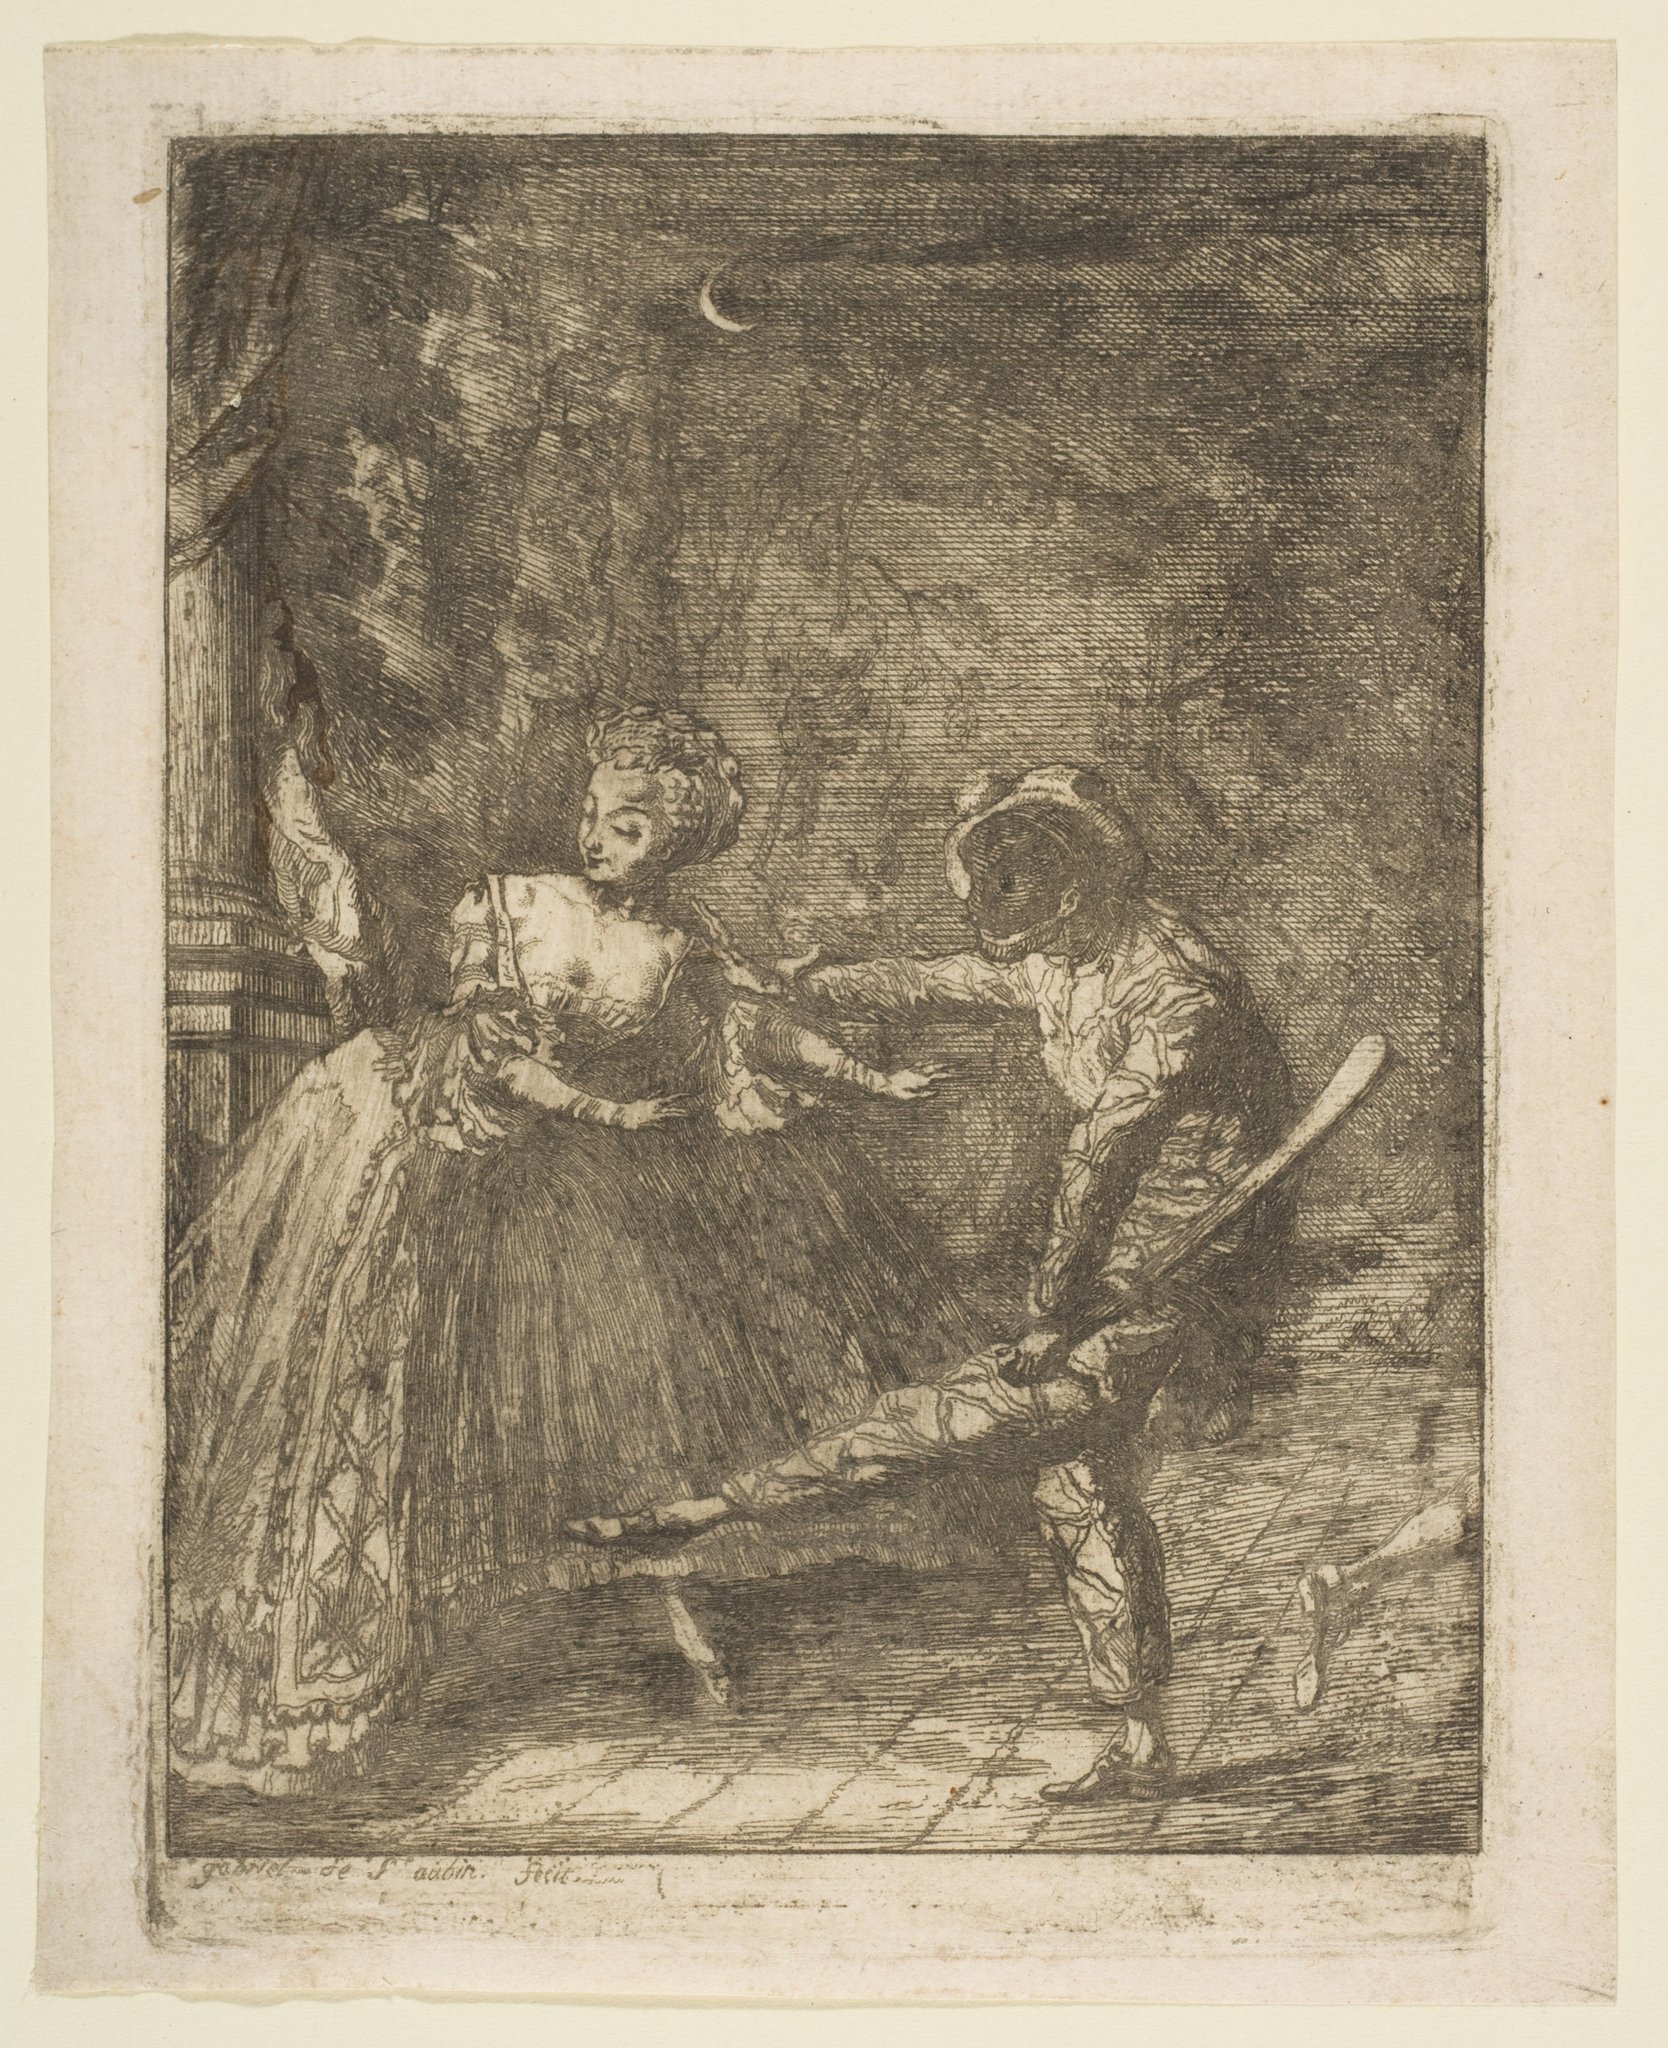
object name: print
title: The Italian Theater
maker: gabriel de saint-aubin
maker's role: artist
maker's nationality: french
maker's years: 1724-1780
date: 1724-1780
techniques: etching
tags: men,women,moon,night